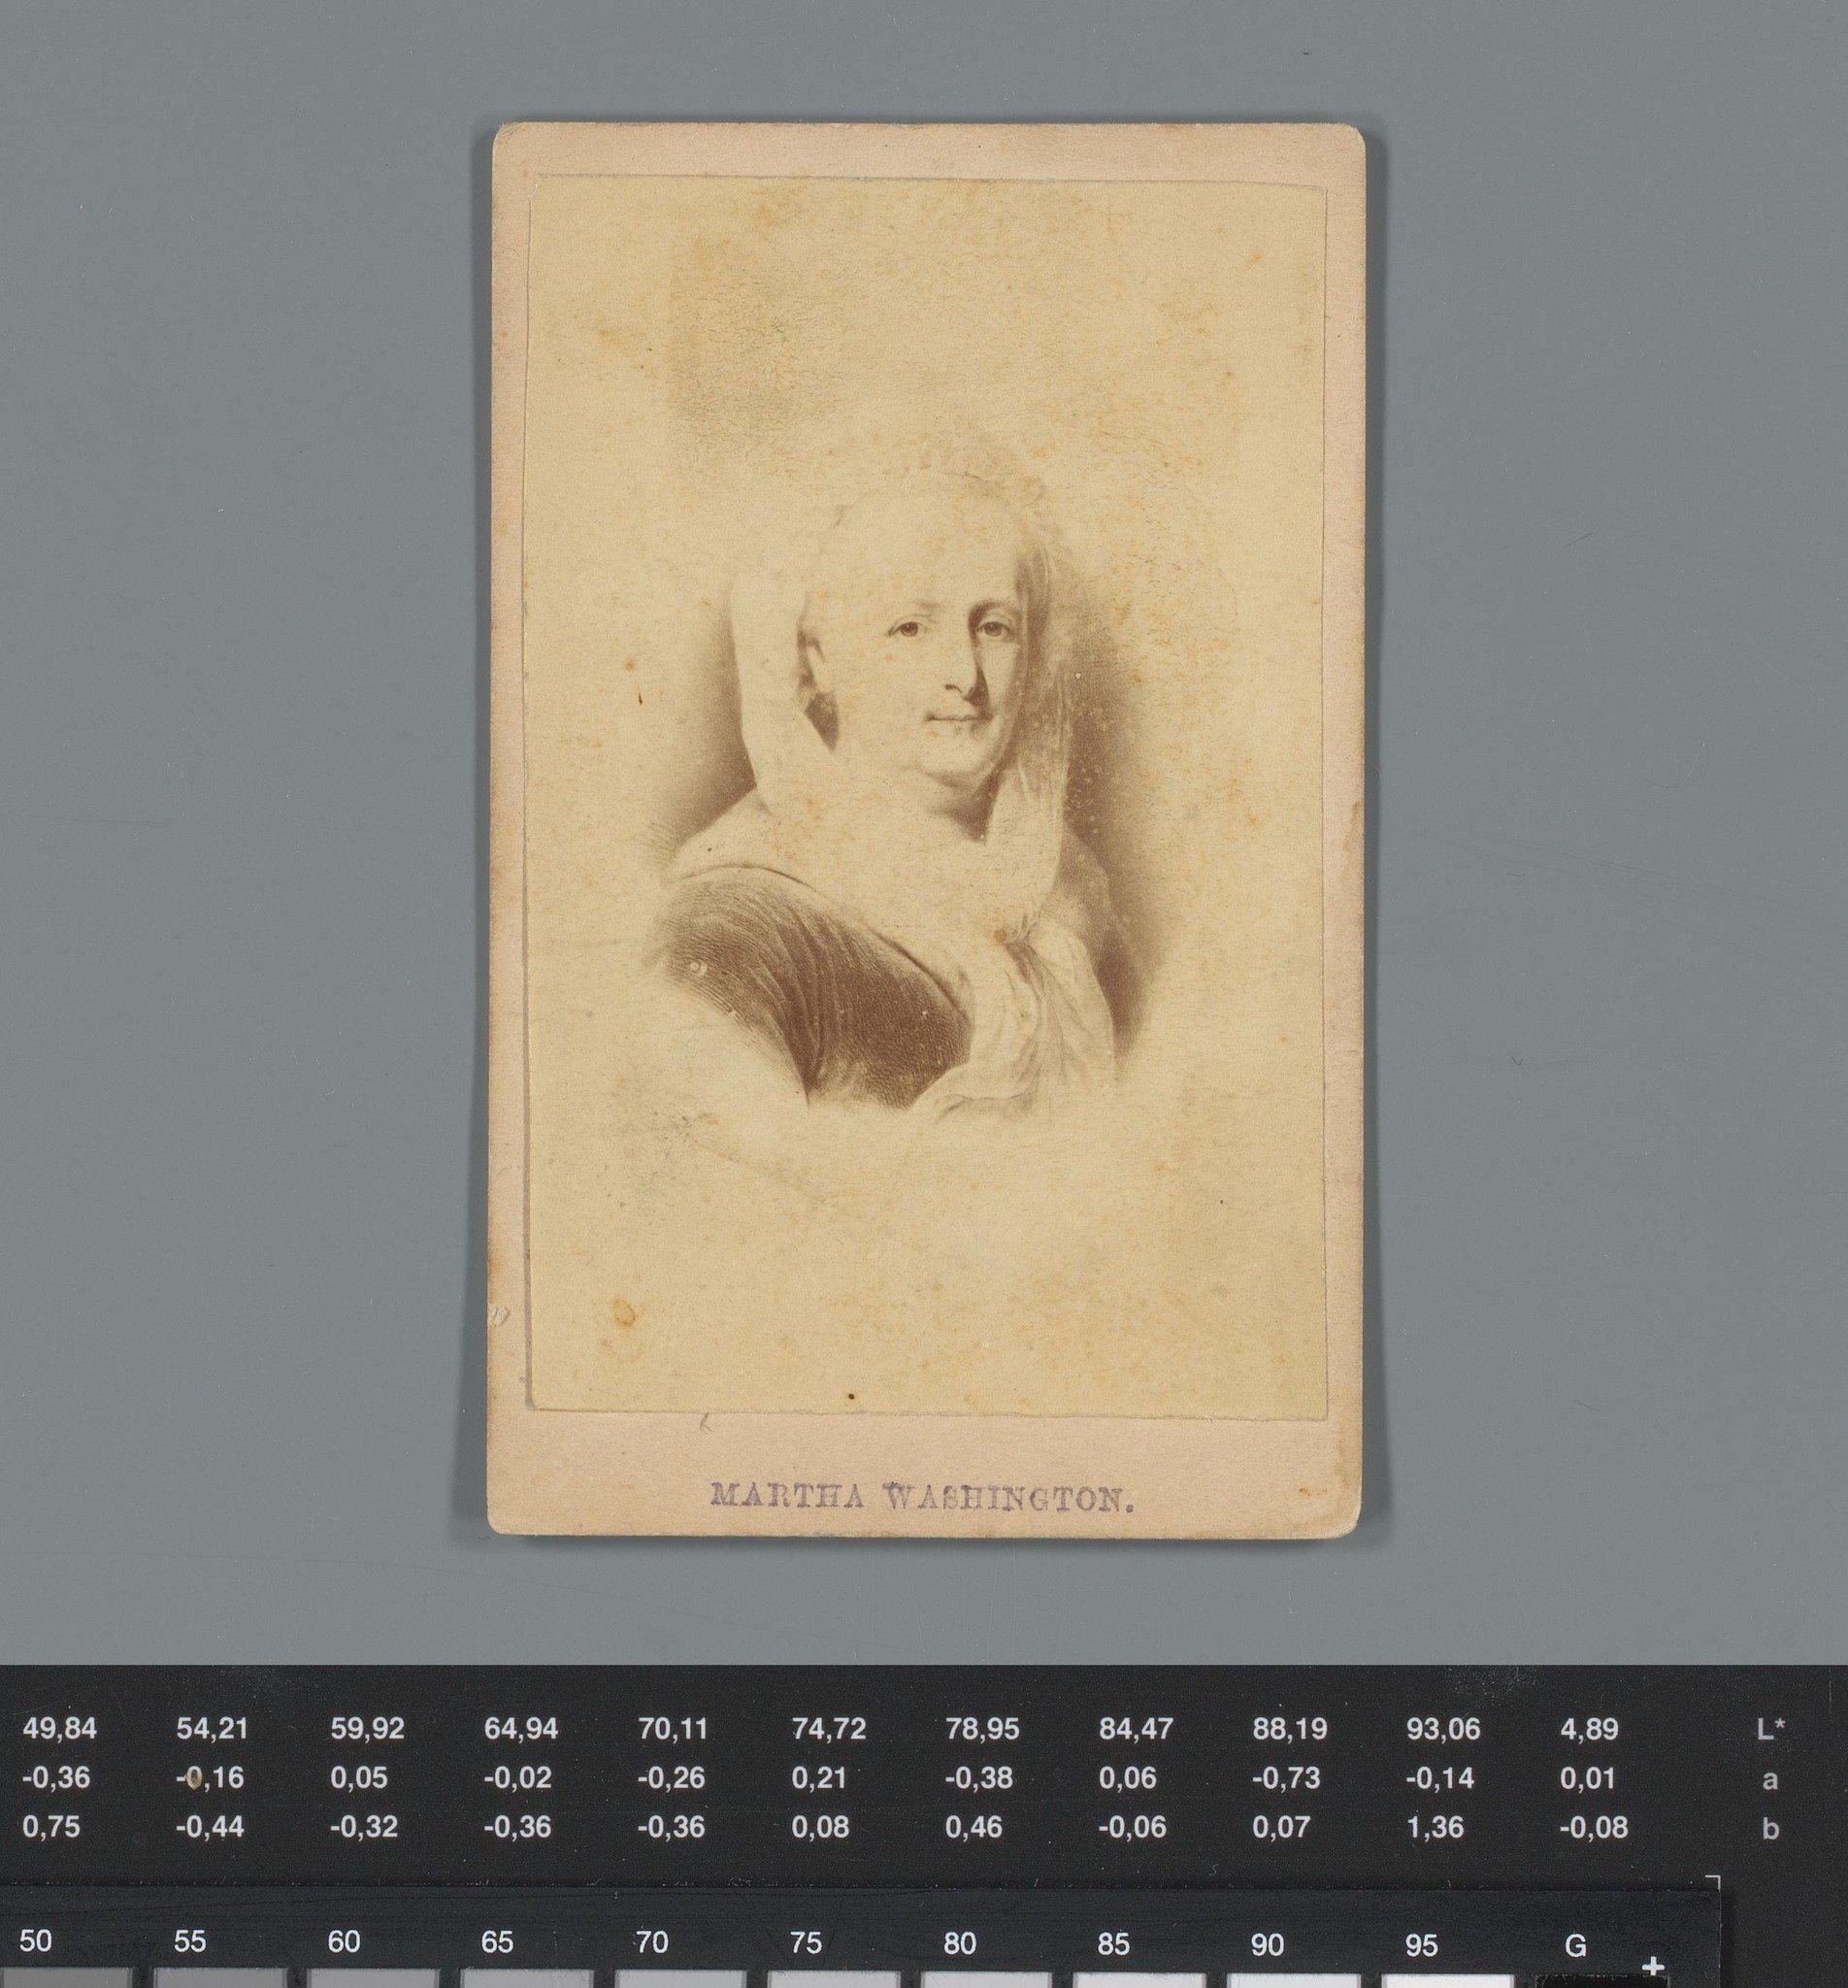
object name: photograph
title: Reclame voor H. Gerken boodschappen met een portret van Martha Washington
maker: Anonymous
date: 1850-1915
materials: cardboard, photographic support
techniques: albumen print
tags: advertising, historical persons - bb - woman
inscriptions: inscription: ‘H. GERKEN, / DEALER IN / FINE GROCERIES, FRUIT, (...)’